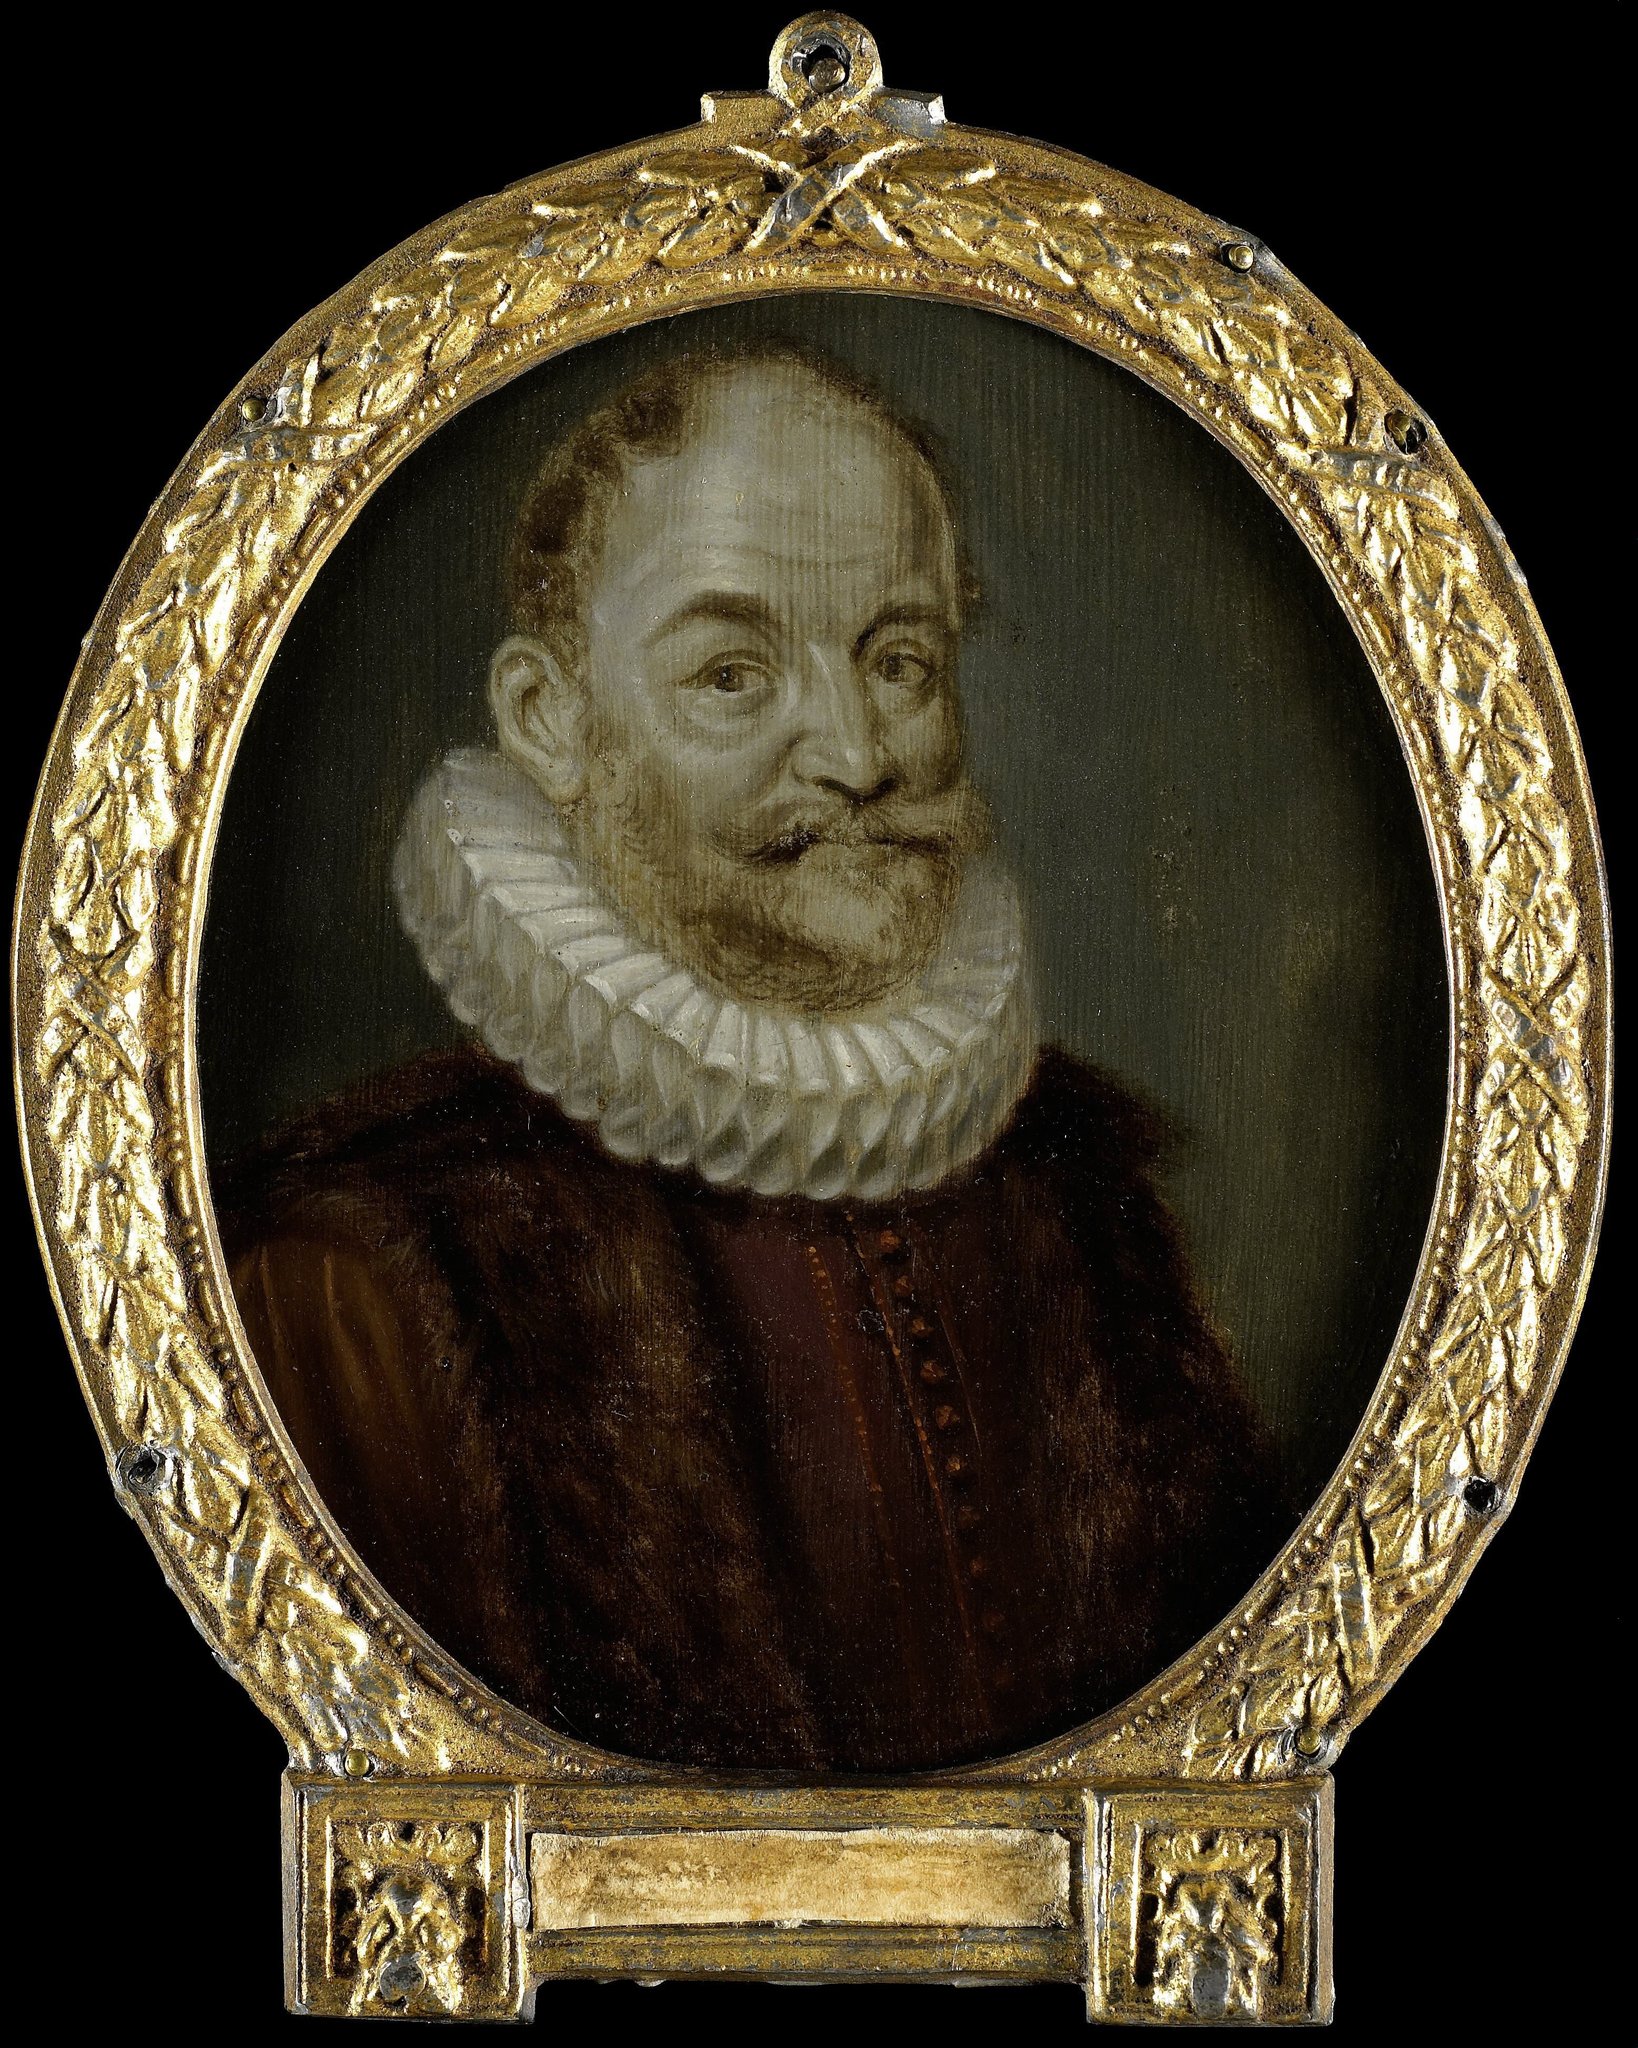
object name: painting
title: Portrait of Johannes Polyander à Kerckhoven, Professor of Theology in Leiden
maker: arnoud van halen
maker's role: draughtsman, painter, print maker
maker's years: 1673-1732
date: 1700-1732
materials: oil, metal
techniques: grisaille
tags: leiden, portrait of a writer, writer, poet, author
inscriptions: inscription: ‘Joannes Poliander. Nat. 1568 / Ob.t 1646’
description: Portret van Johannes Polyander van Kerckhoven (1568-1646). Hoogleraar in de godgeleerdheid te Leiden. Buste in ovaal, naar rechts. Onderdeel van een verzameling portretten van Nederlandse dichters.